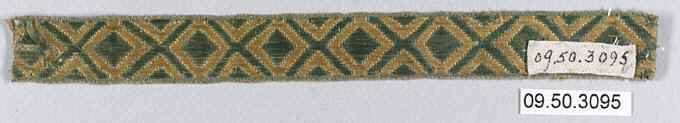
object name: gimp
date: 1701-1900